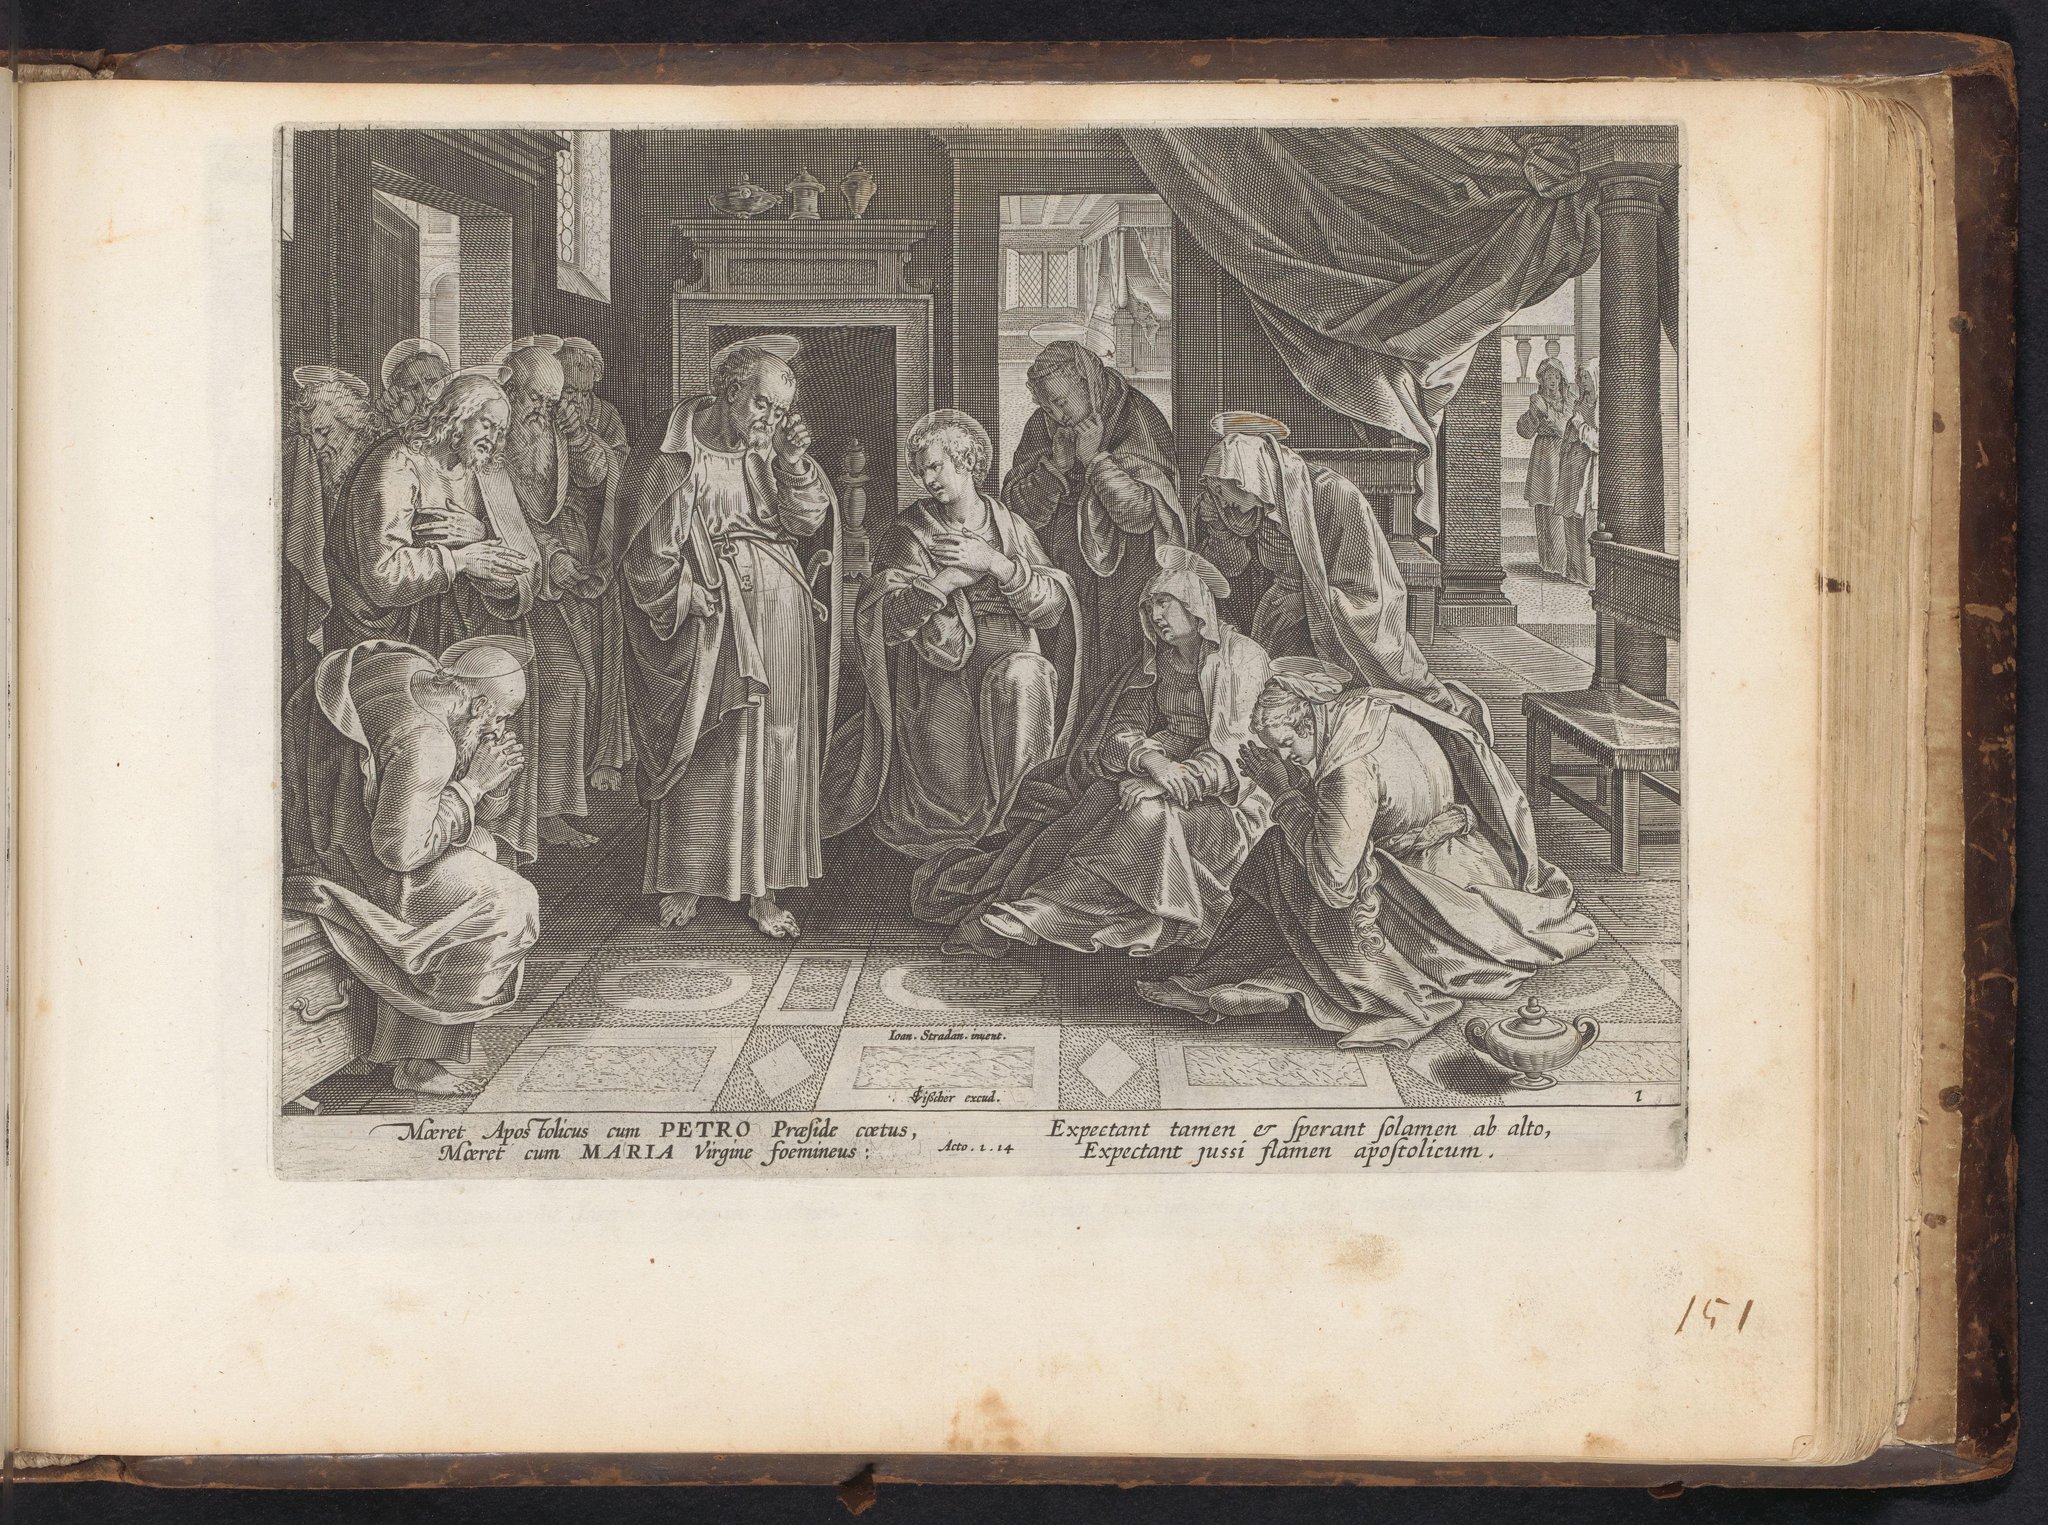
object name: print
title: Den Grooten Figuer-Bibel (...)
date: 1547-1612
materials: paper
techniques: engraving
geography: alkmaar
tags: disciples awaiting the return of christ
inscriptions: number: ‘151’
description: Centraal in een woonkamer de apostelen, Maria en enkele vrouwen. Ze rouwen om de hemelvaart van Christus en bidden. Onder de voorstelling een verwijzing in het Latijn naar de Bijbeltekst in Hand. 1:14. Deze prent maakt deel uit van een album.